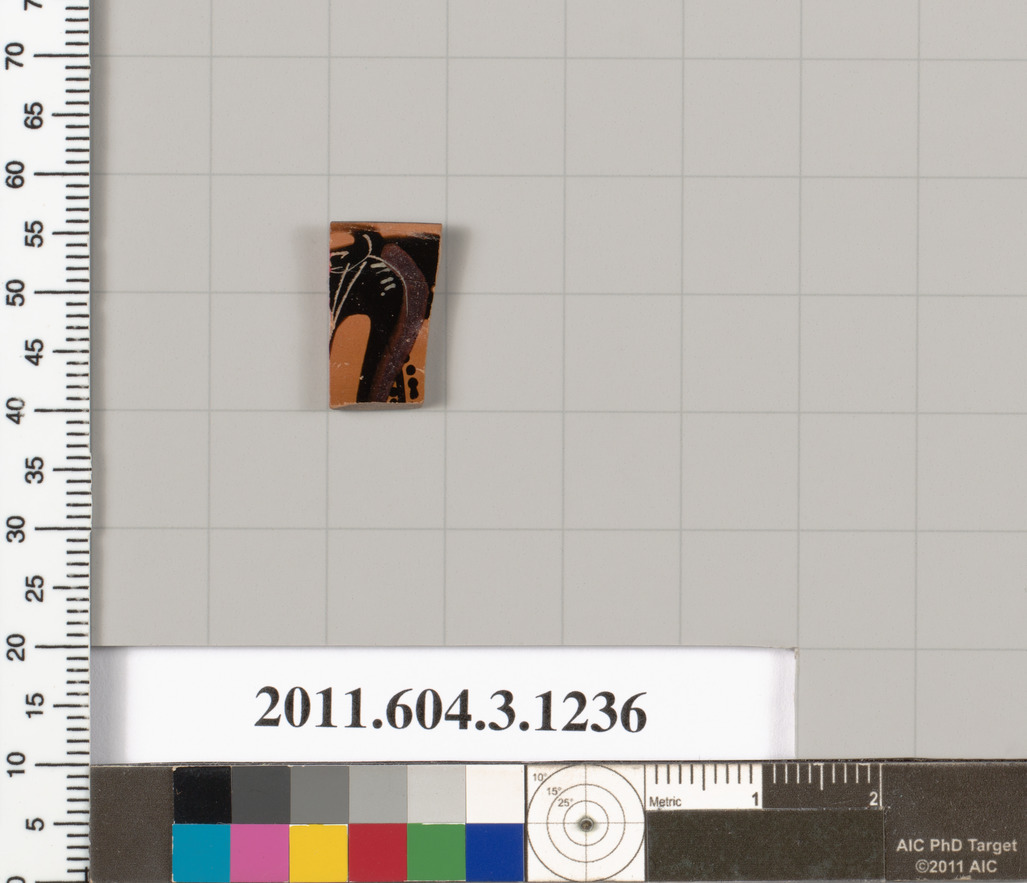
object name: kyathos fragment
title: Terracotta rim fragment of a kyathos (cup-shaped ladle)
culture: greek, attic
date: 534-468 BCE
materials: terracotta